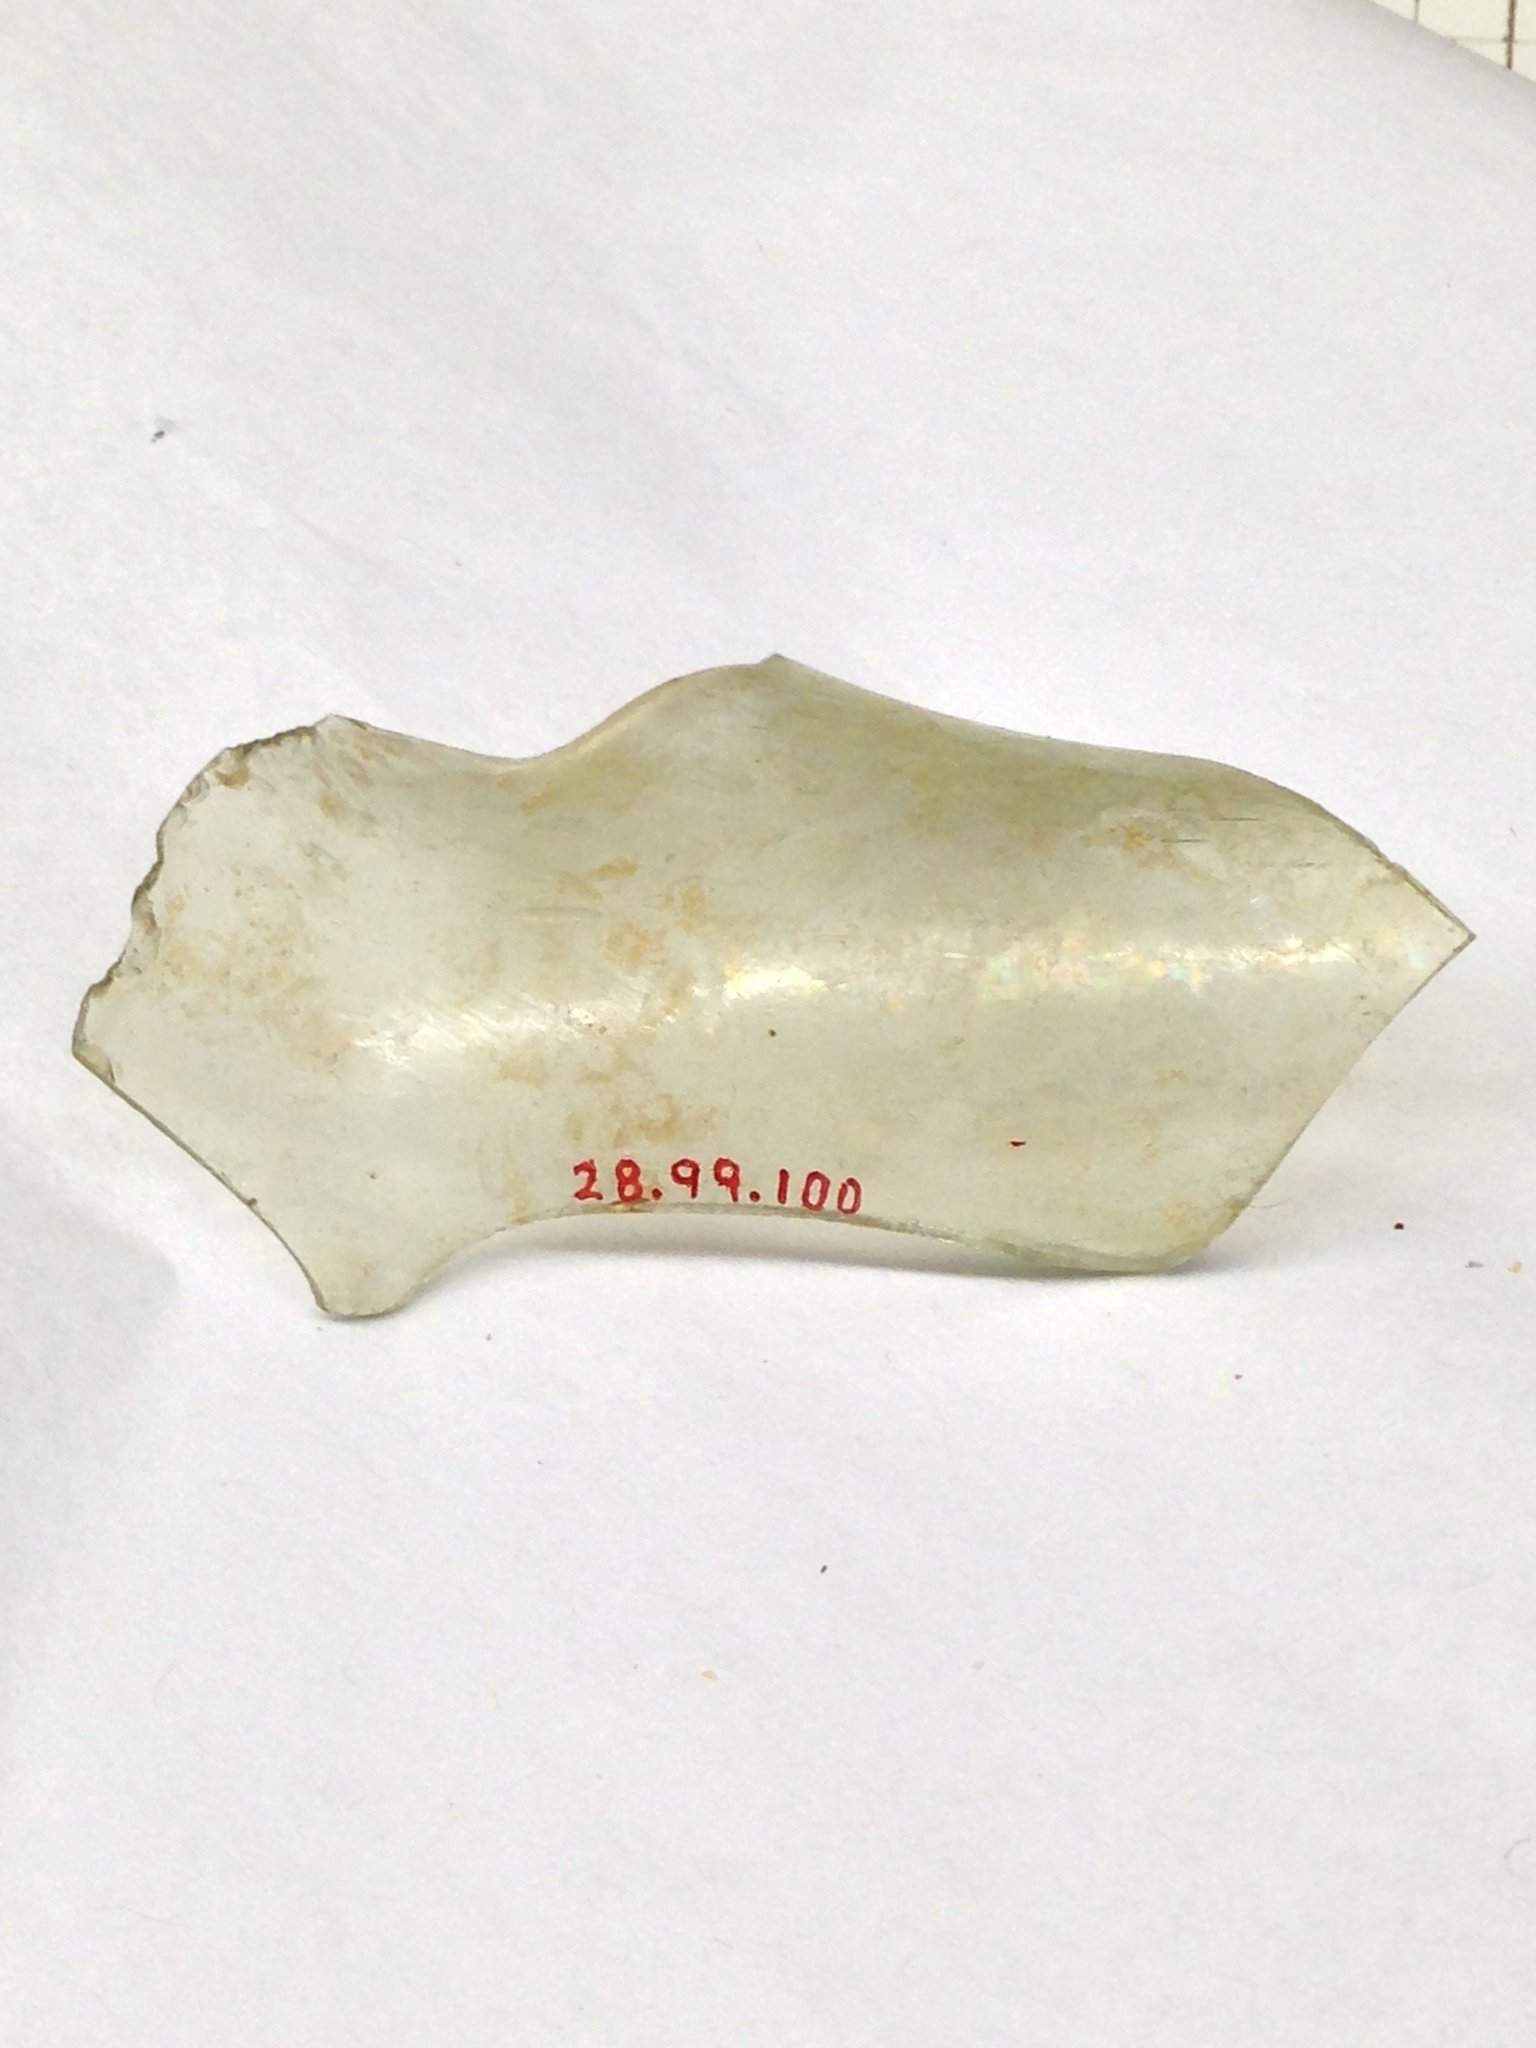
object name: fragment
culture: european or middle eastern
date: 1150-1250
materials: ceramic, glass